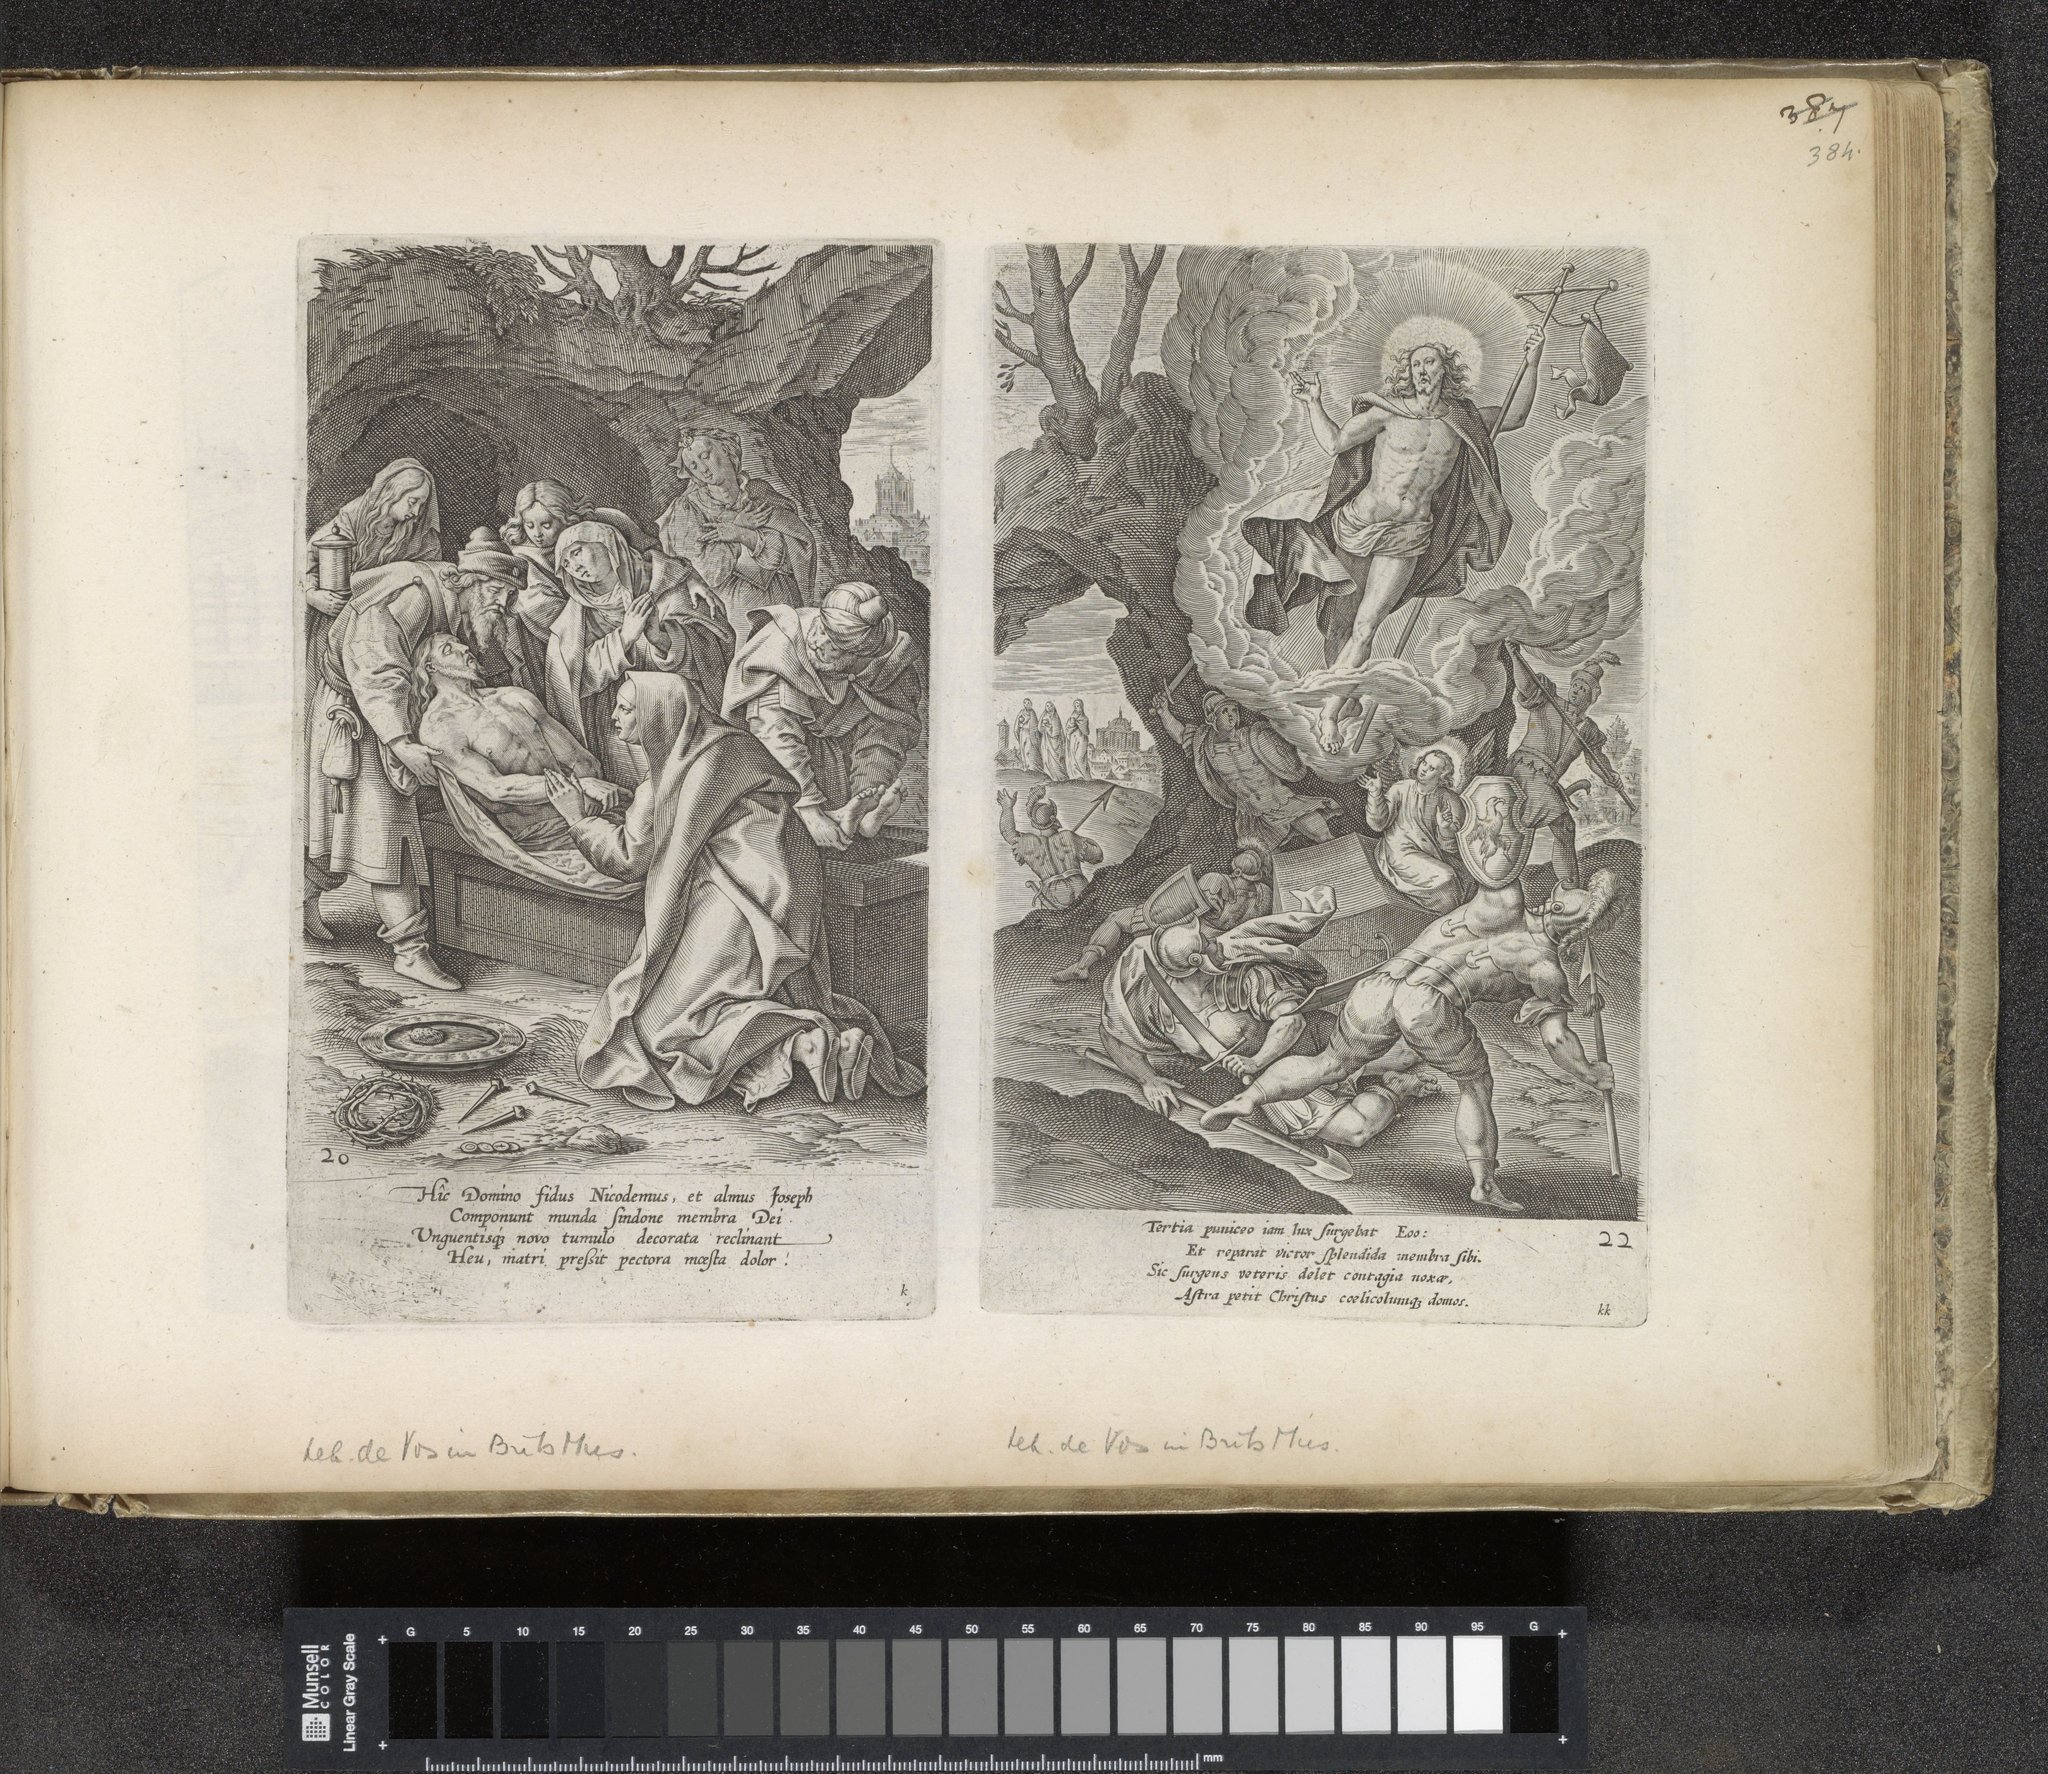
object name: print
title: Theatrum Biblicum Hoc Est Historiae Sacrae Veteris et Novi Testamenti Tabulis Aeneis Expressae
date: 1585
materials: paper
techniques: engraving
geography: amsterdam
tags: christ's entombment (possibly by angels)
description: Christus wordt door Josef van Arimatea en Nikodemus in het rotsgraf gelegd. Rond het graf de treurende heilige vrouwen. Op de voorgrond de passiewerktuigen. Onder de voorstelling een vierregelig vers in het Latijn. Rechtsonder de letter: k. Deze prent maakt deel uit van een album.